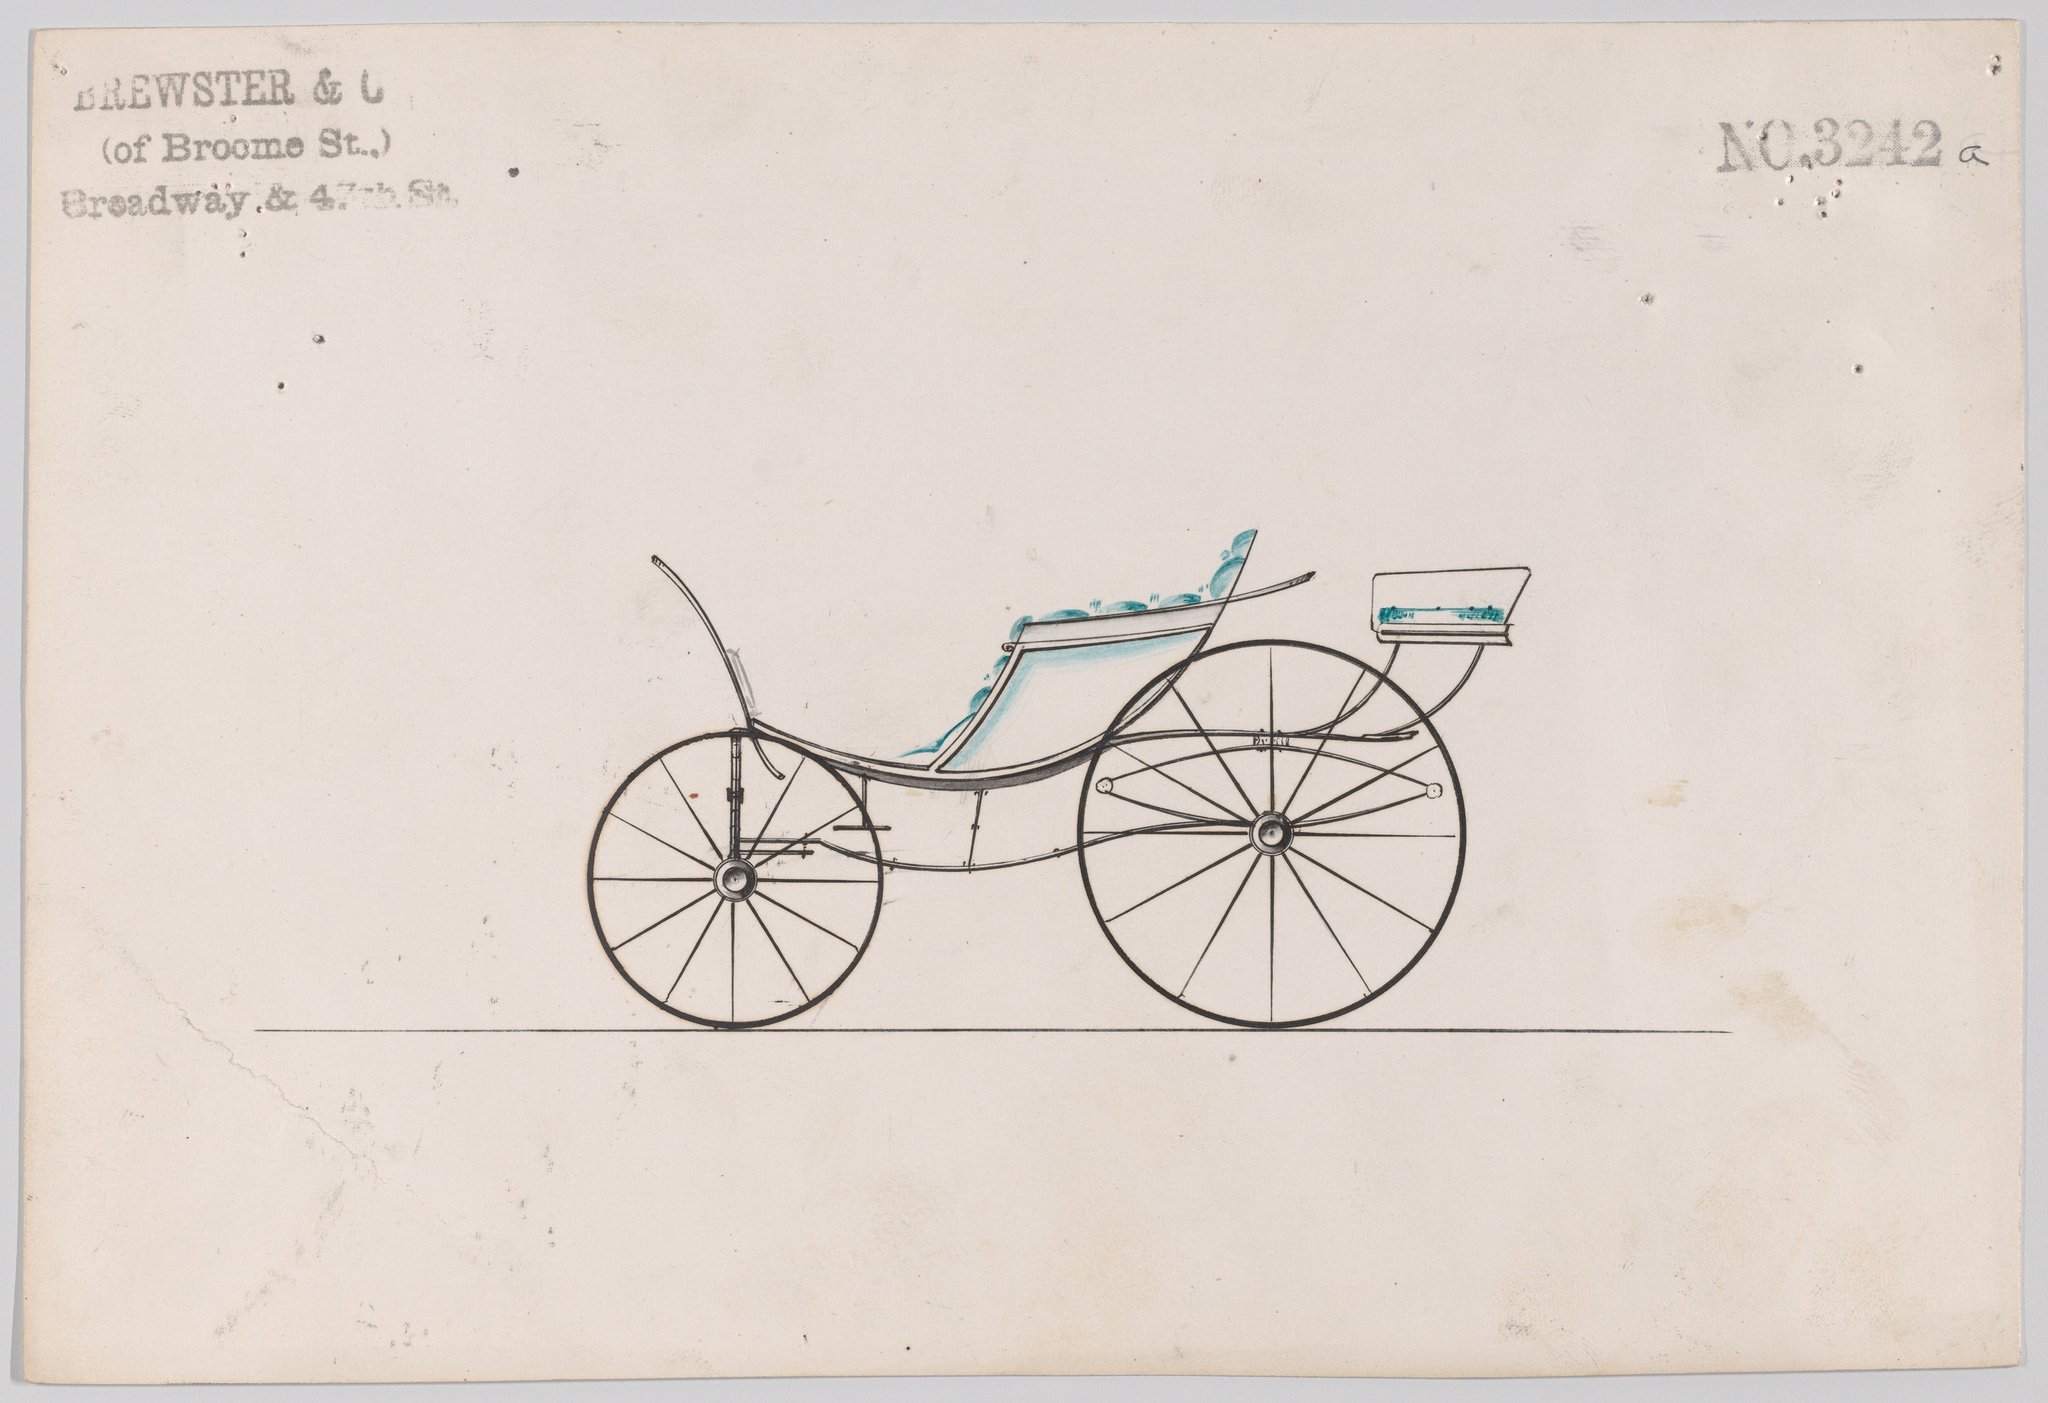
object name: drawing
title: Design for Pony Phaeton, no. 3242a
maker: brewster & co.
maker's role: manufacturer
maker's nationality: american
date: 1876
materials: gouache, ink, watercolor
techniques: pen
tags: carriages